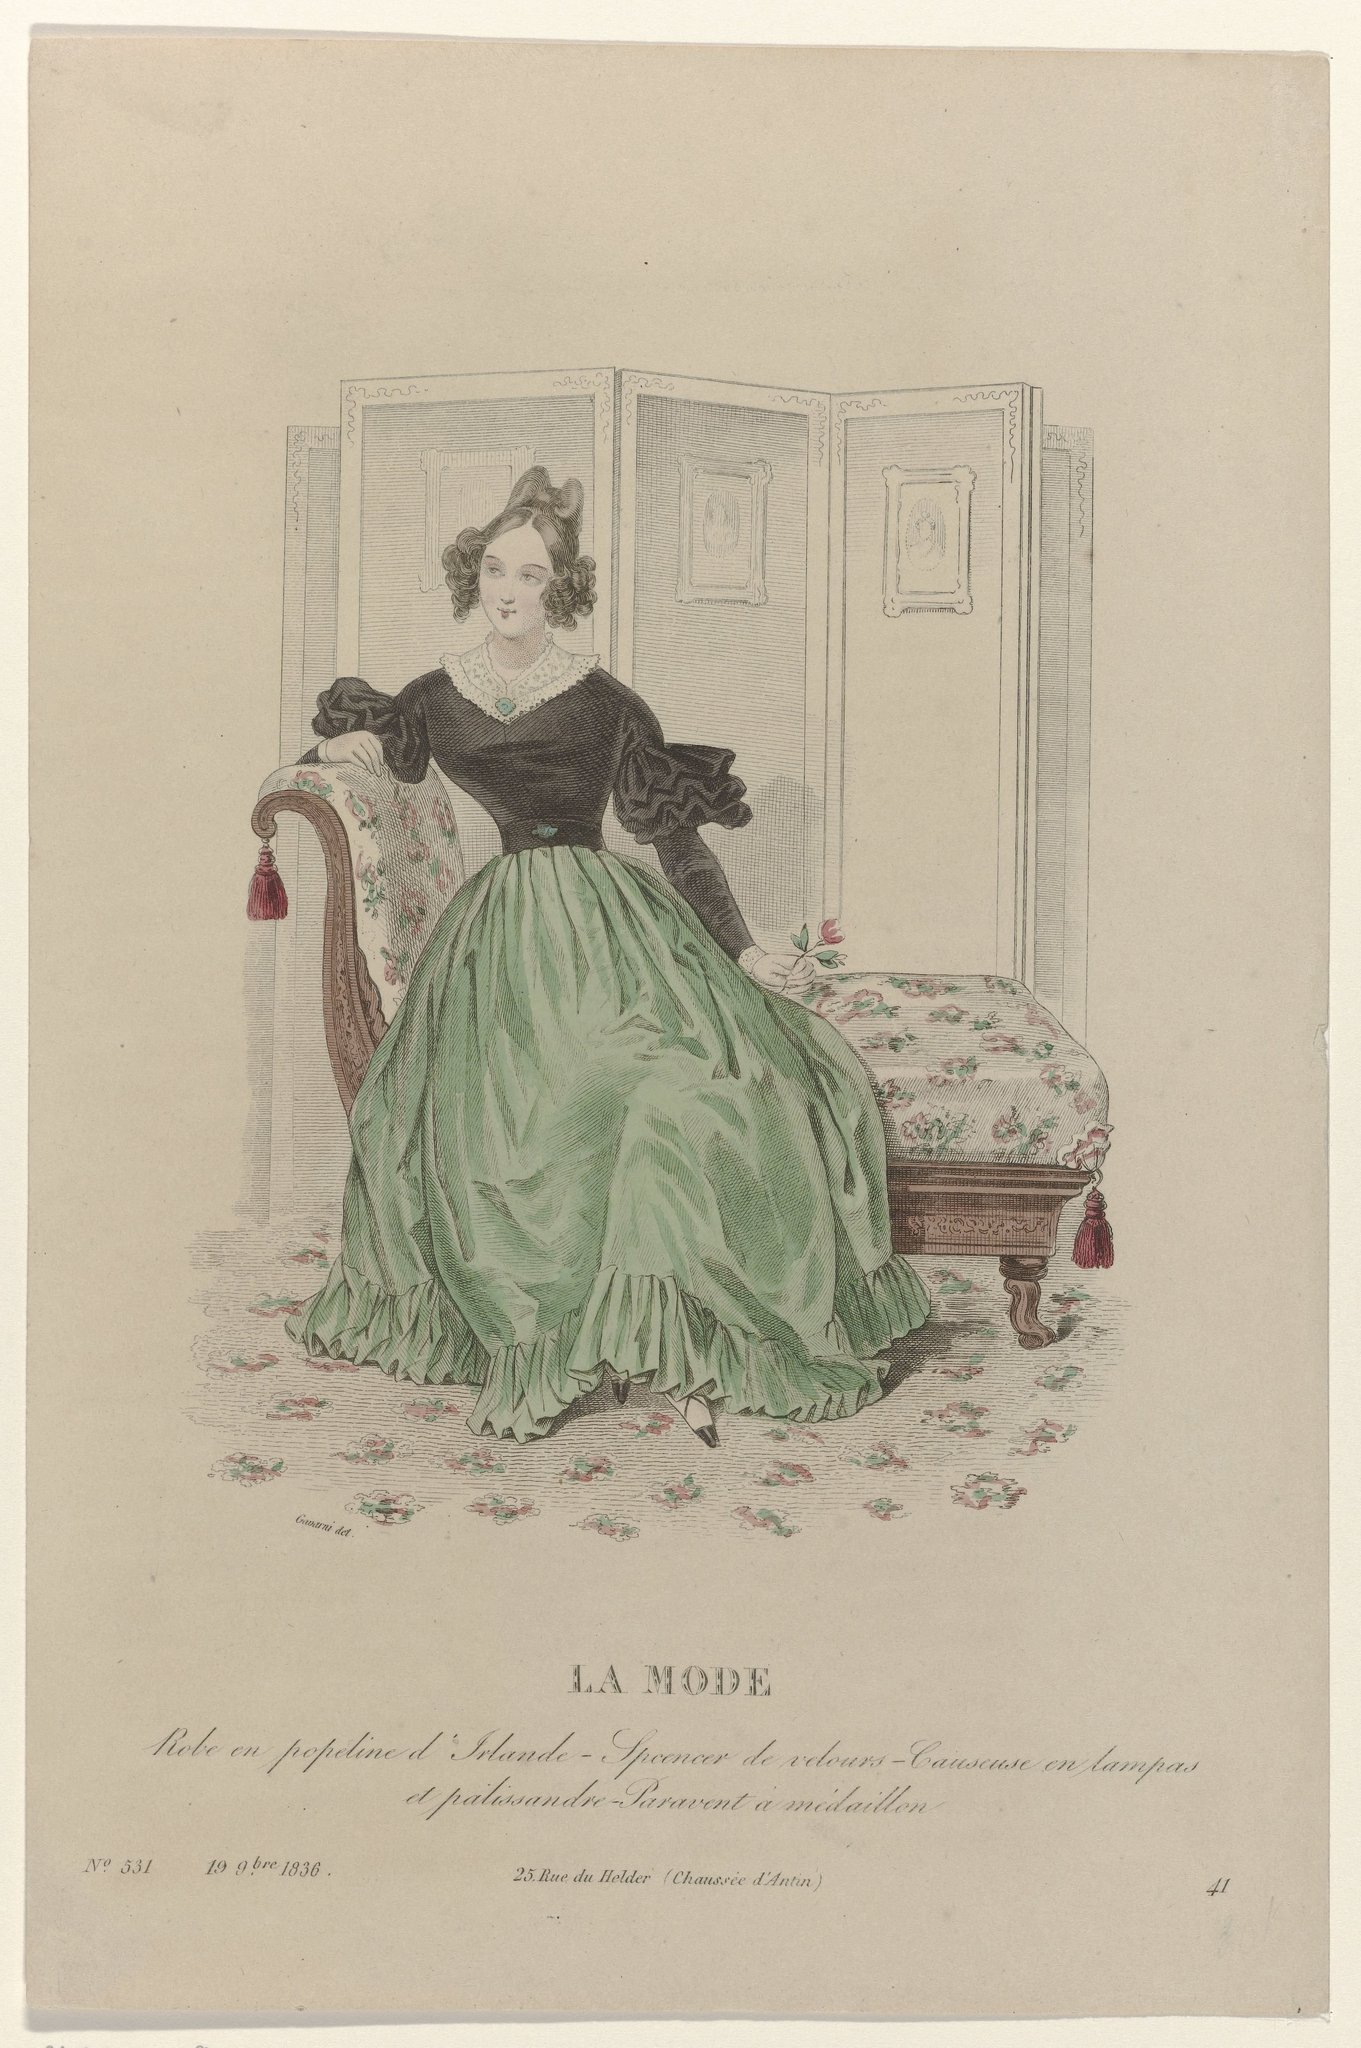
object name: fashion print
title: La Mode, 19 novembre 1836, No. 531: Robe en popelin (...).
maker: Anonymous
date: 1836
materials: paper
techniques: engraving, hand coloring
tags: cut flowers; nosegay, bunch of flowers, brooch, agraffe, clasp (+ women's clothes), clothing for the upper part of the body (spencer) (+ women's clothes), fashion plates, shoes, sandals (+ women's clothes), dress, gown (+ women's clothes), screen, folding screen, couch, sofa, settee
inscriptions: address: ‘25. Rue du Helder (Chaussée d'Antin)’, title: ‘La Mode’, caption: ‘Robe en popeline d'Irlande - Spencer de velours - Causeuse en lampas et palissandre - Paravent à médaillon’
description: Zittende vrouw op een Causeuse (tweepersoonsbankje) van lampas en palissanderhout. Achter haar staat een kamerscherm versierd met medaillons. Zij draagt een fluwelen spencer op een japon van 'popeline d'Irlande'. Prent uit het modetijdschrift La Mode (1829-1855).